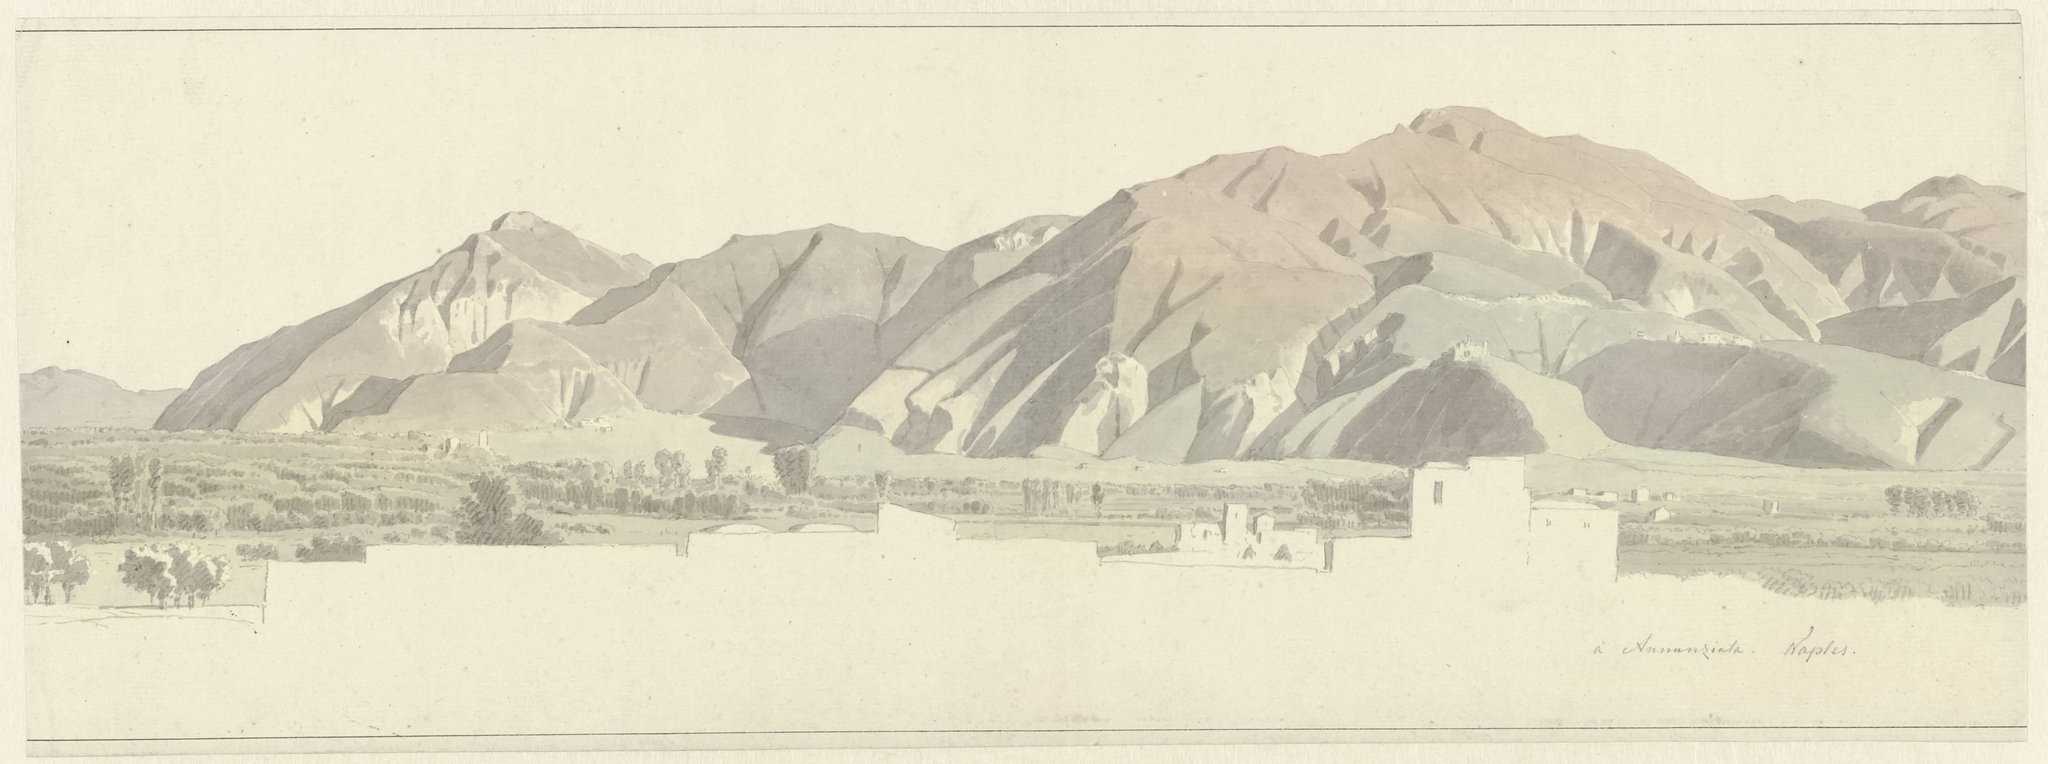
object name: drawing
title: Mount Vesuvius, with Torre Annunziata (?)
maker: josephus augustus knip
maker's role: draughtsman, painter, print maker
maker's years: 1777-1847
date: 1811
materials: graphite, paper, watercolor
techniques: brush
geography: italy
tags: mountains, mount vesuvius, naples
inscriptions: inscription: ‘à Annunziata. Naples.’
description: Knip’s annotation led to some confusion. While there is a place called Annunziata, it lies more to the south, farther south even than Naples, on the same peninsula as Sorrento. The place depicted here is clearly situated at the foot of the volcano near Naples. This must be Torre Annunziata, on the southern slope of Mount Vesuvius. It is now an industrial town.